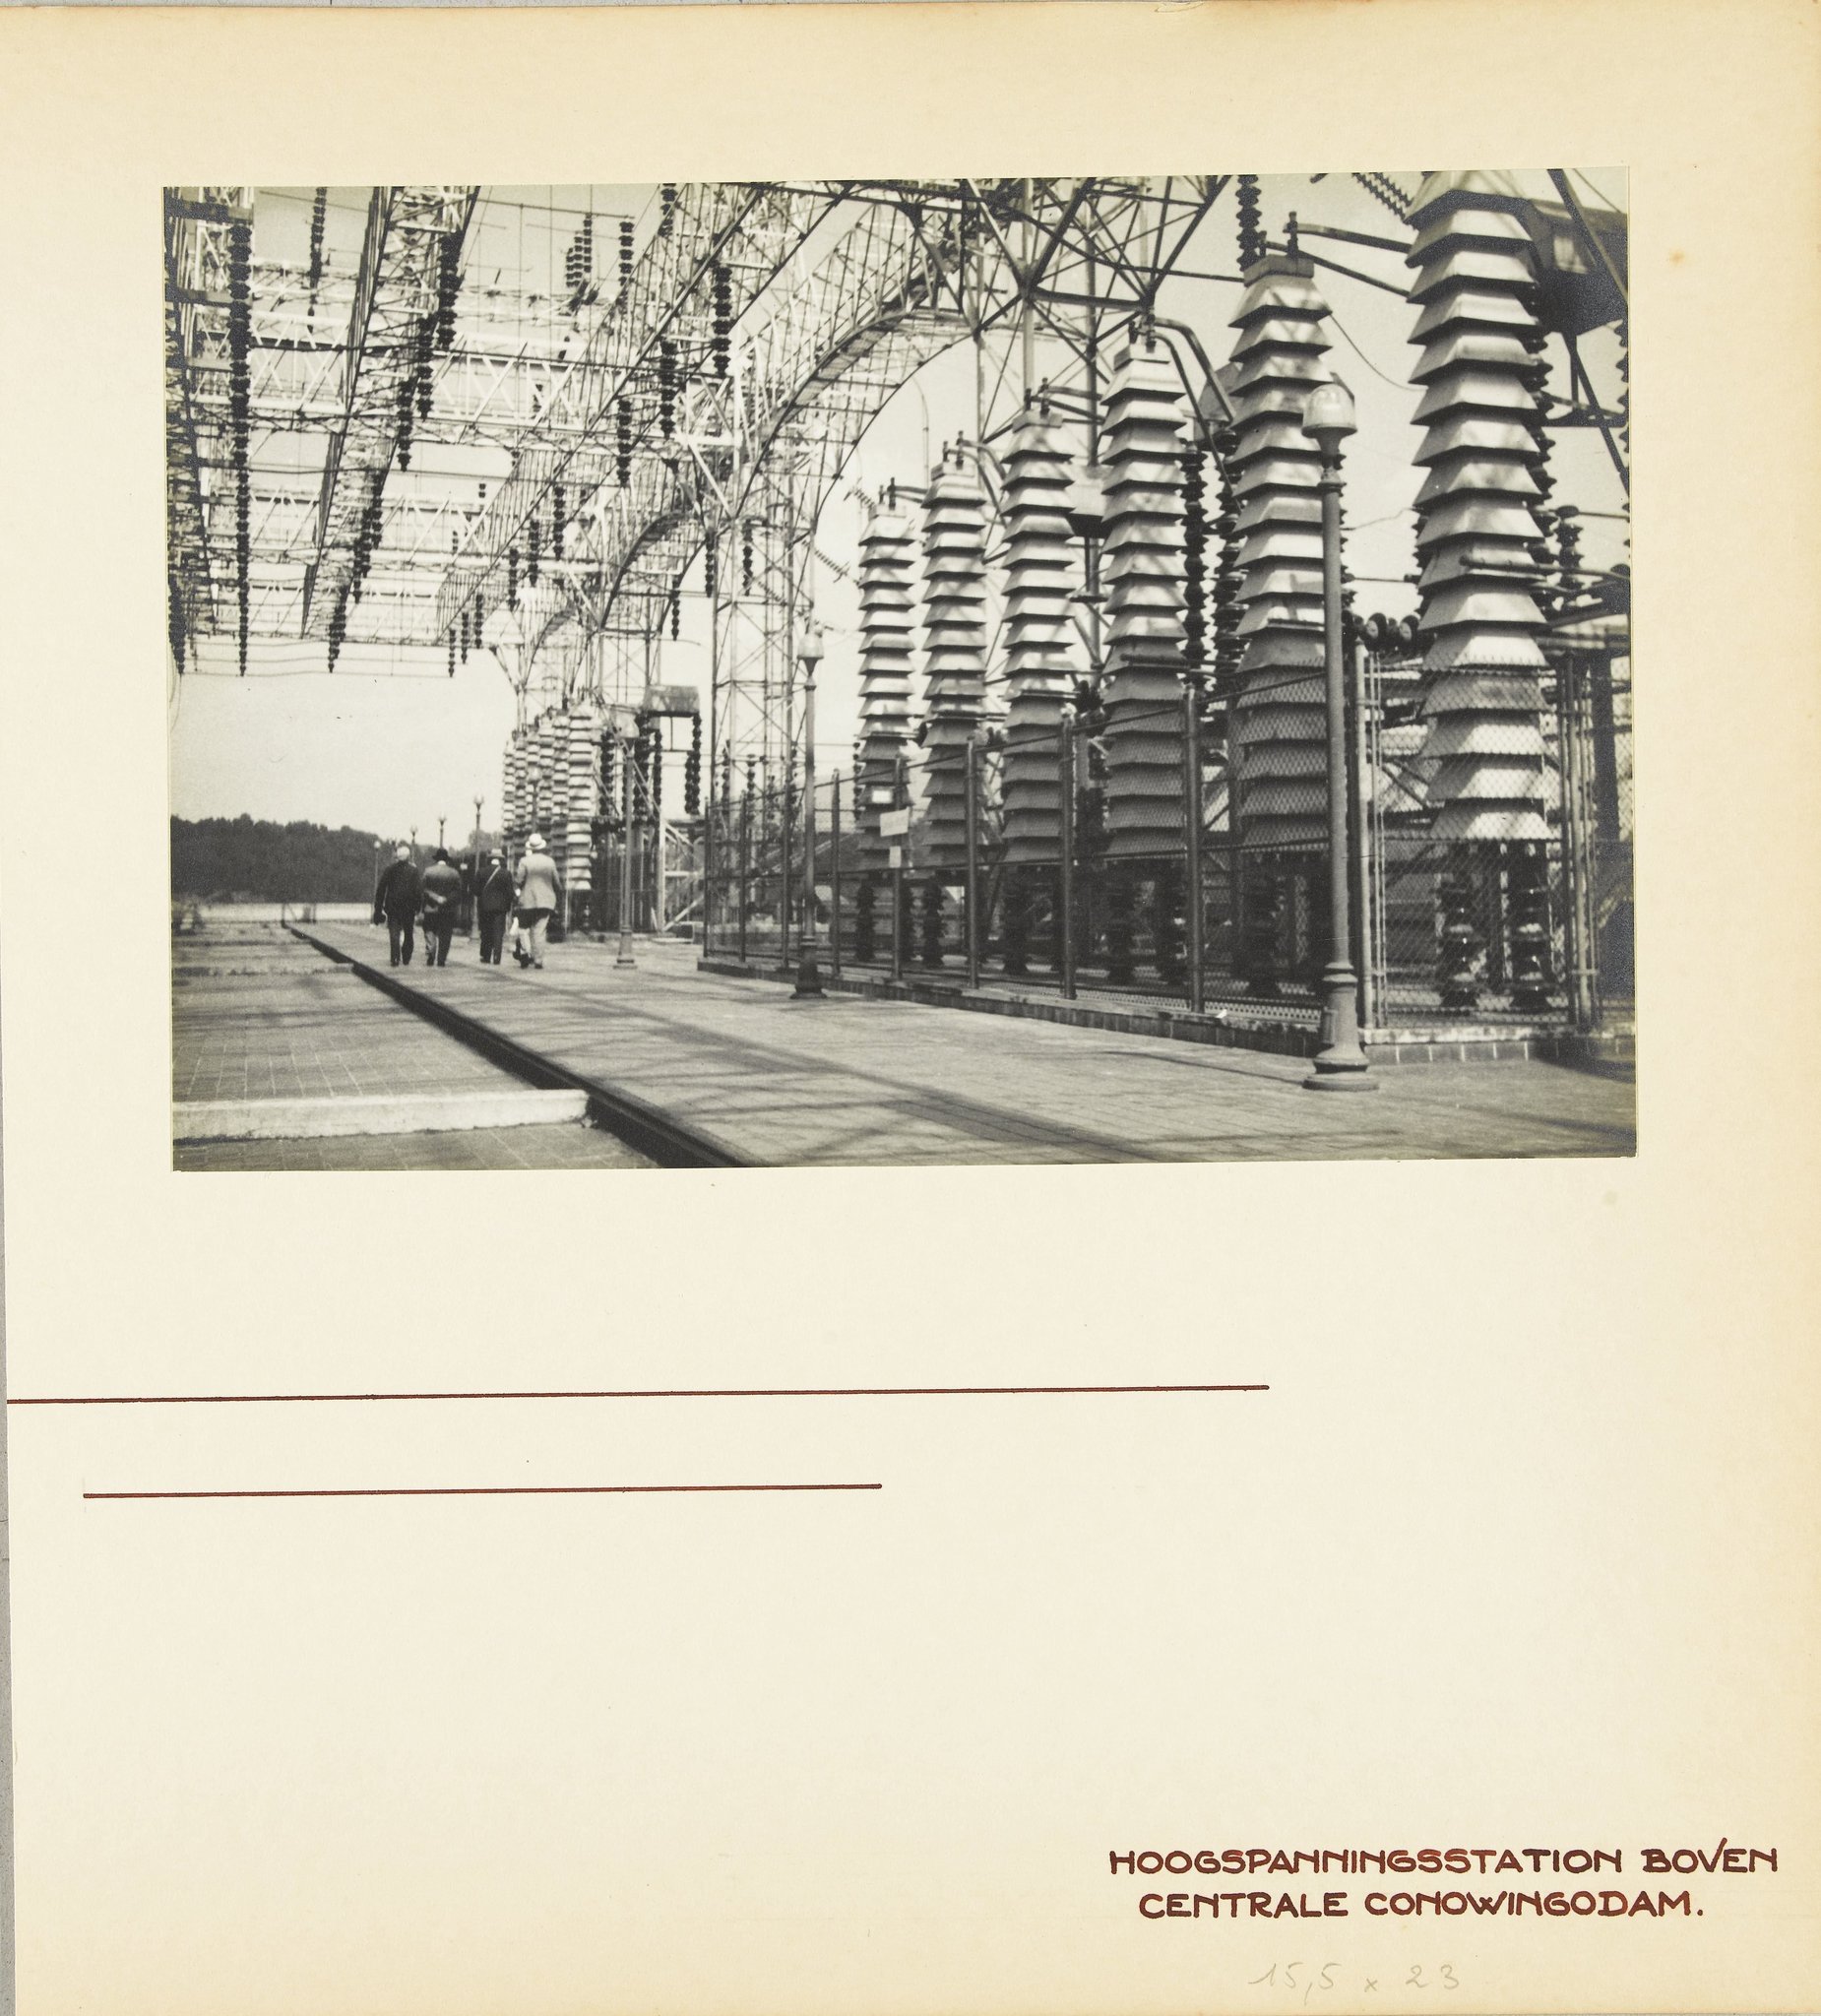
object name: photograph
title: Hoogspanningsstaion boven centrale Conowingodam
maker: wouter cool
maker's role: engineer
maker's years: 1877-1947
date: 1936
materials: cardboard, paper, photographic support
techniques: gelatin silver print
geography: united states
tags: dam (in canal)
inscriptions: title: ‘HOOGSPANNINGSSTATION BOVEN / CENTRALE CONOWINGODAM.’